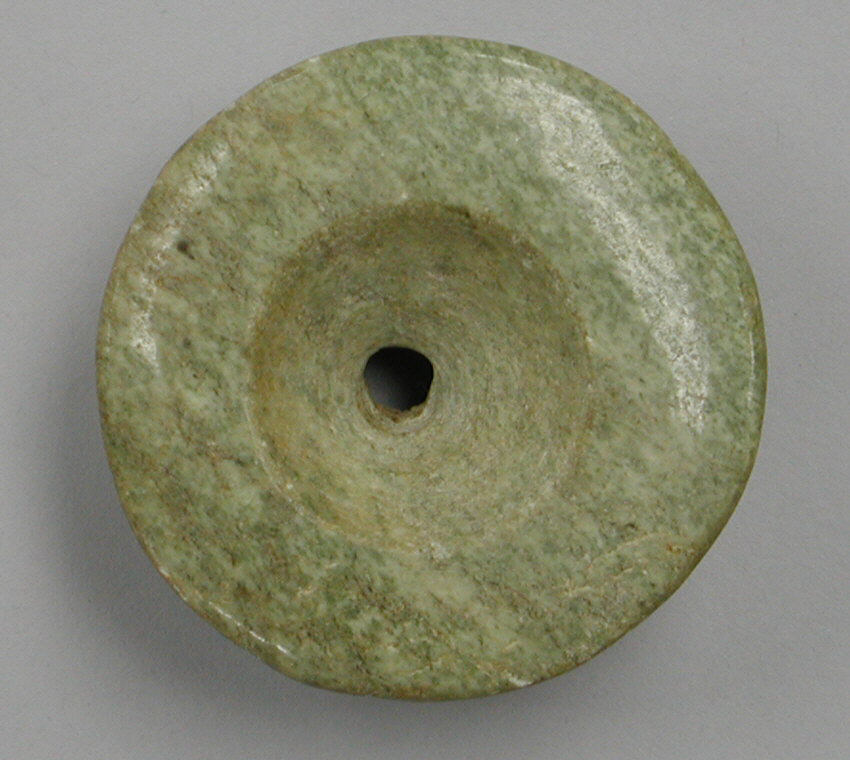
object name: earflare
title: Stone Earflare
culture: mexican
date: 1501-1600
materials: stone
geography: mexico